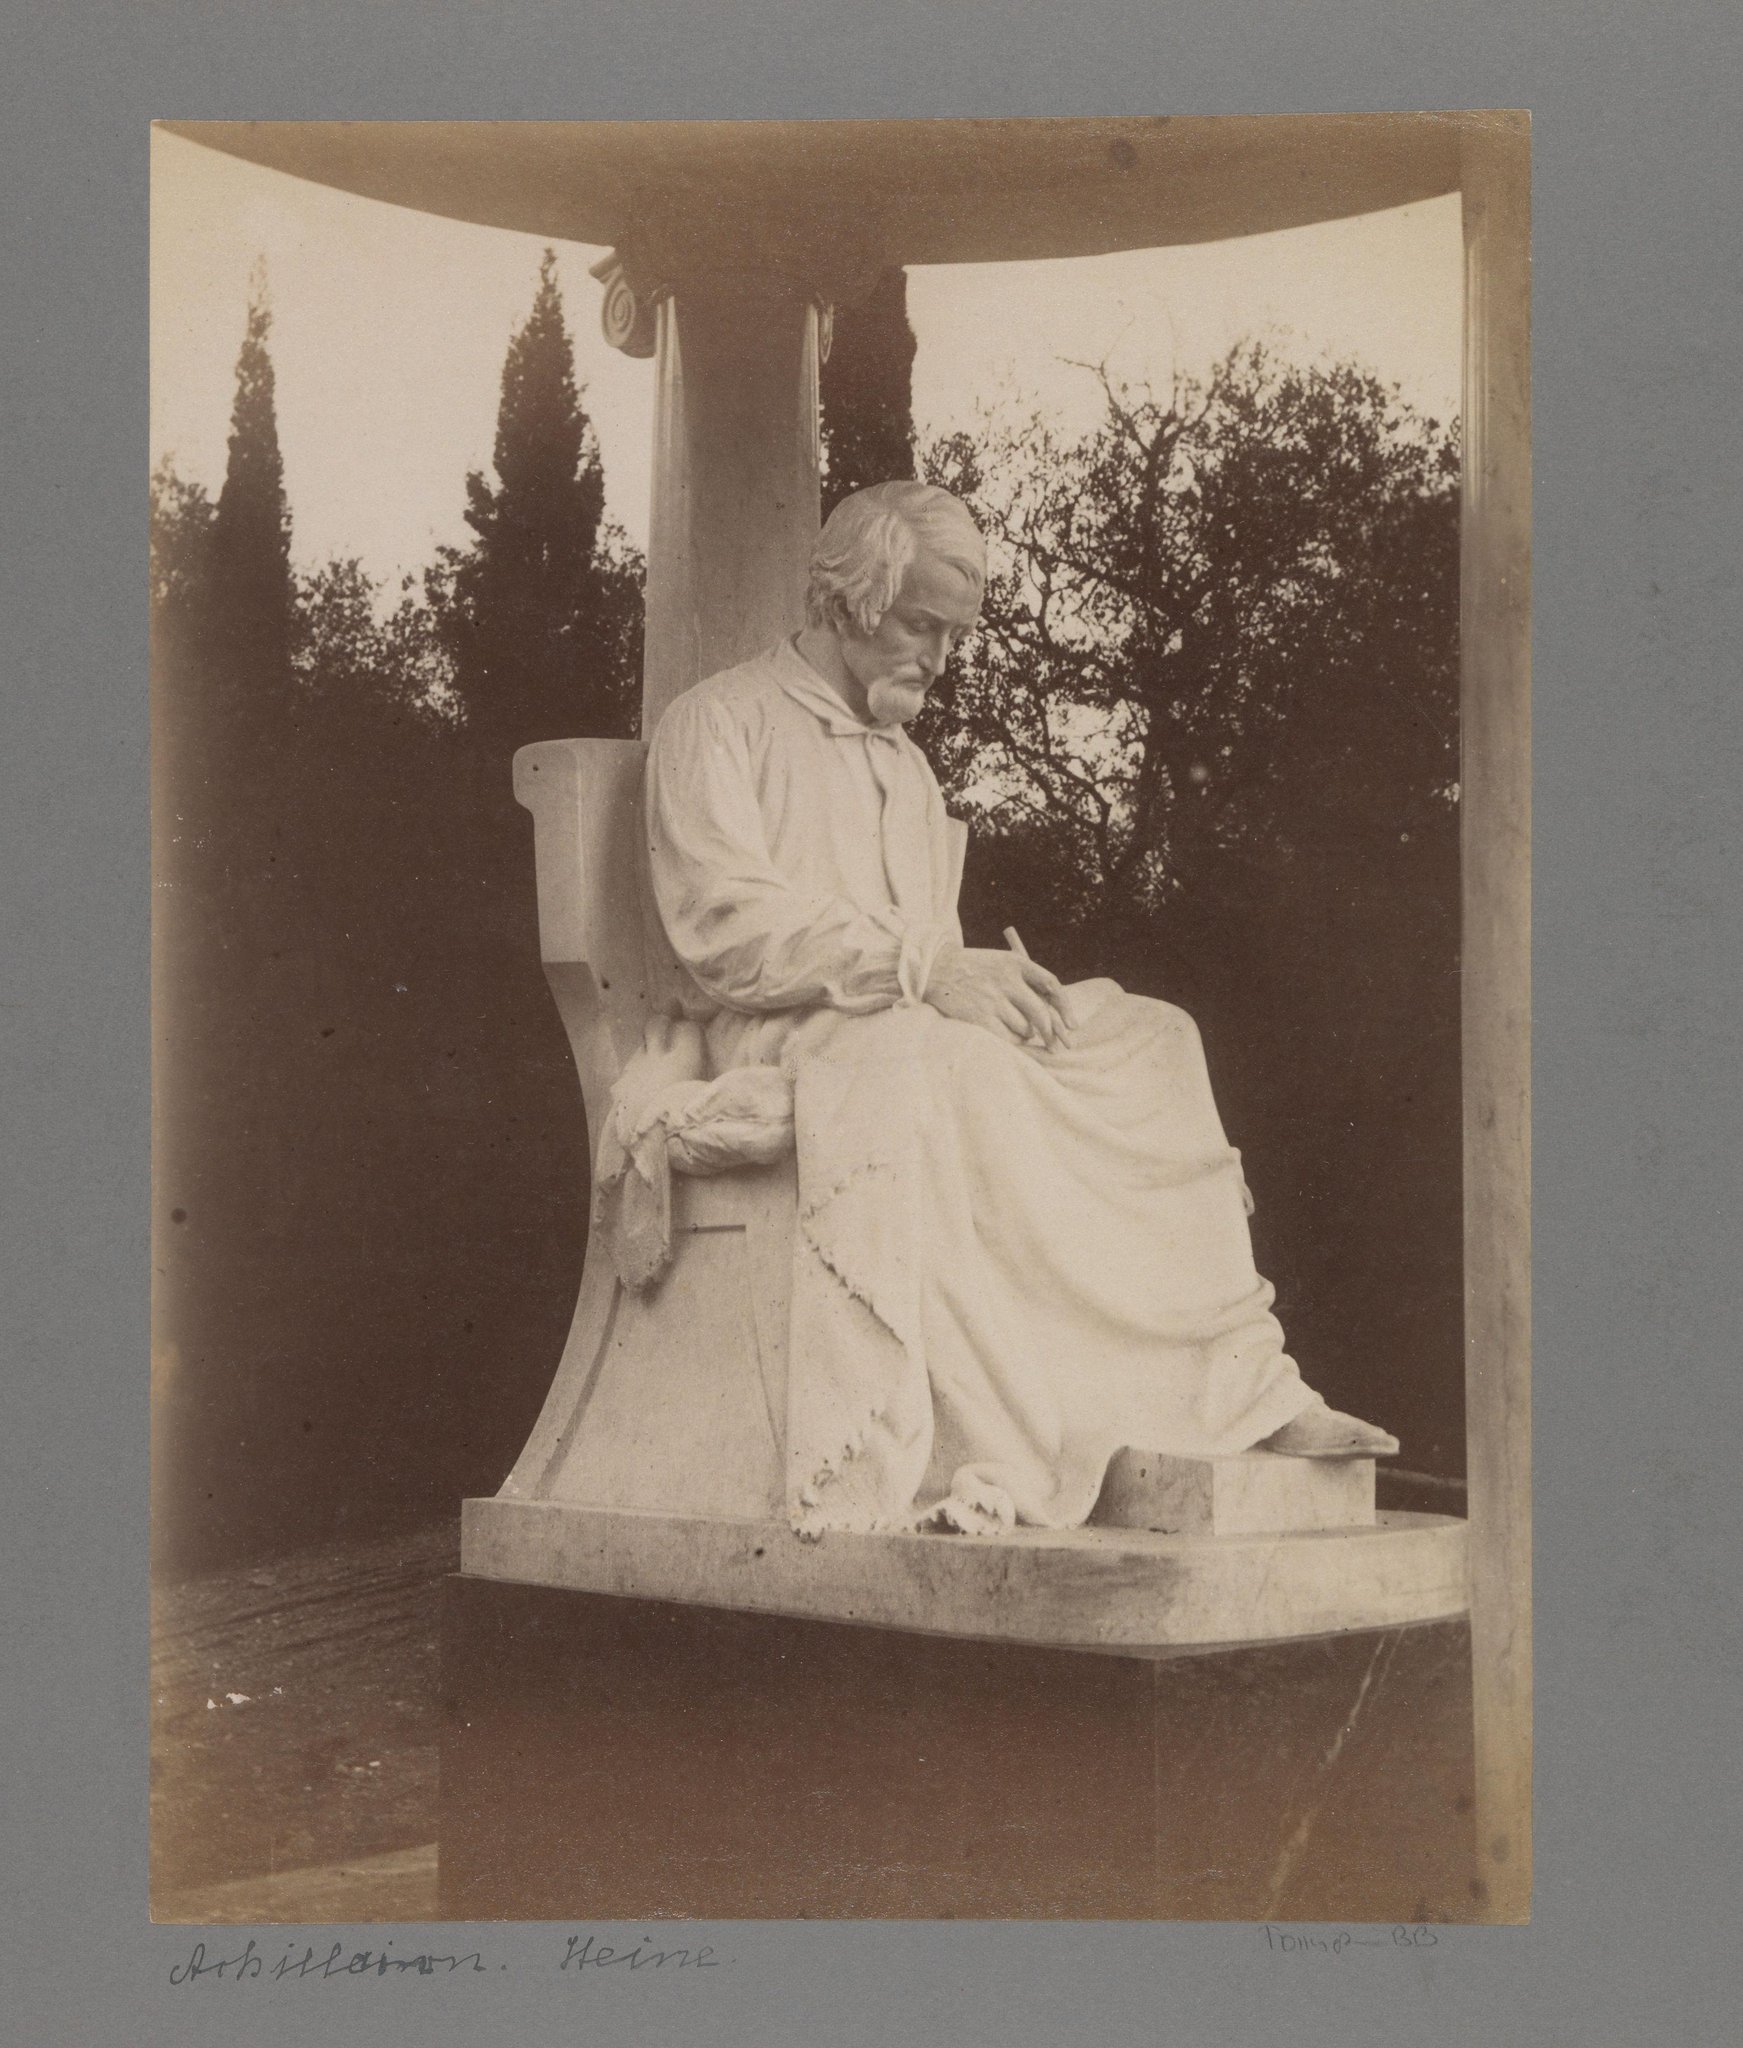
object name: album leaf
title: Beeld van Heinrich Heine bij het Achilleion op Corfu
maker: Anonymous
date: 1895-1905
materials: paper, photographic support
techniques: albumen print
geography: corfu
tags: piece of sculpture, reproduction of a piece of sculpture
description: Onderdeel van Reisalbum met foto's van bezienswaardigheden in Griekenland en Egypte.